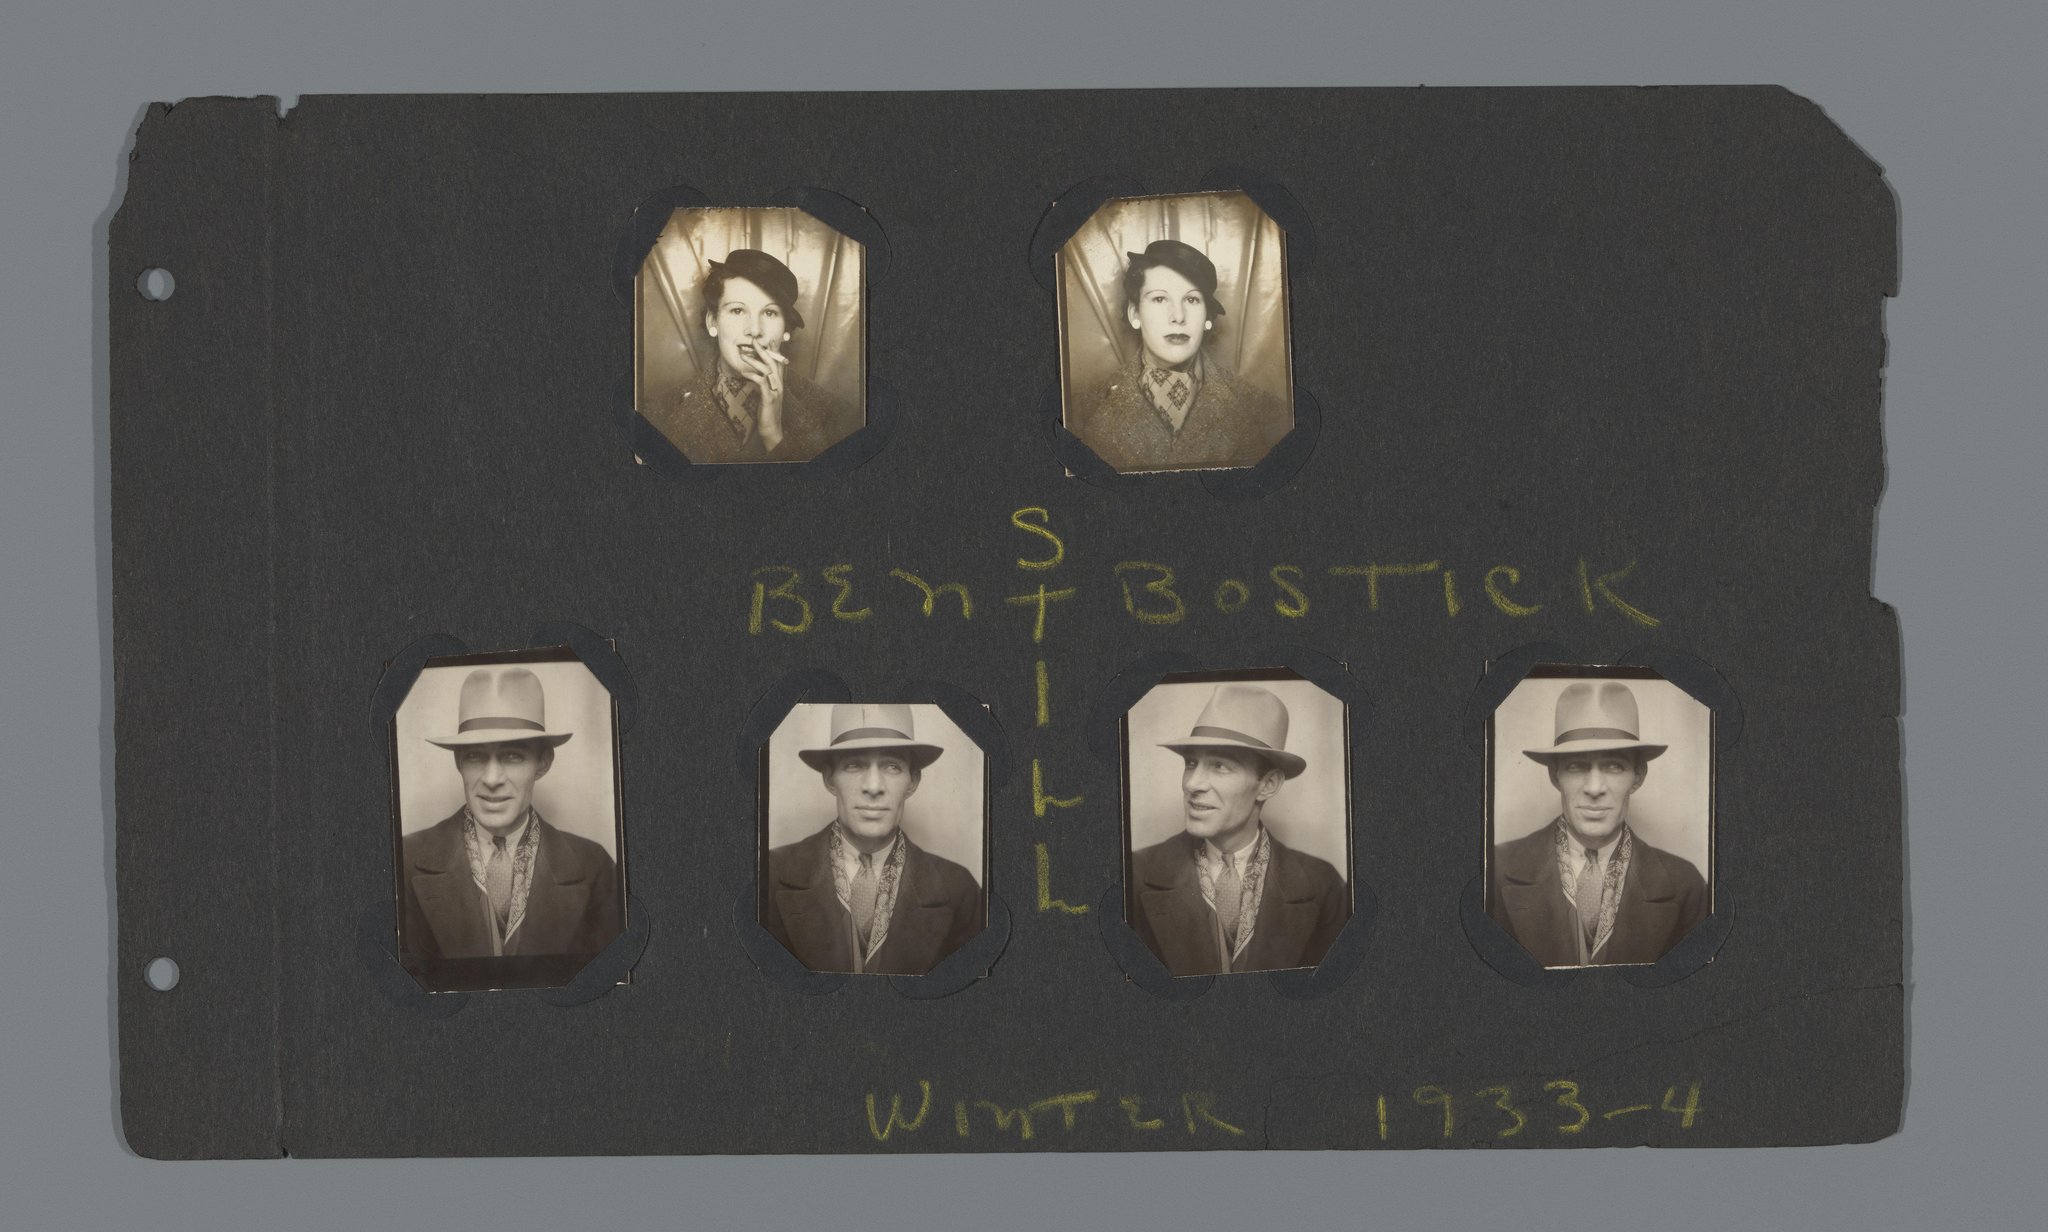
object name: photograph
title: Albumblad met portretten van Ben en Sill (?) Bostick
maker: Anonymous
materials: paper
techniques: gelatin silver print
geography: united states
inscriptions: inscription: ‘BEN + SILL BOSTICK/ WINTER 1933-4’